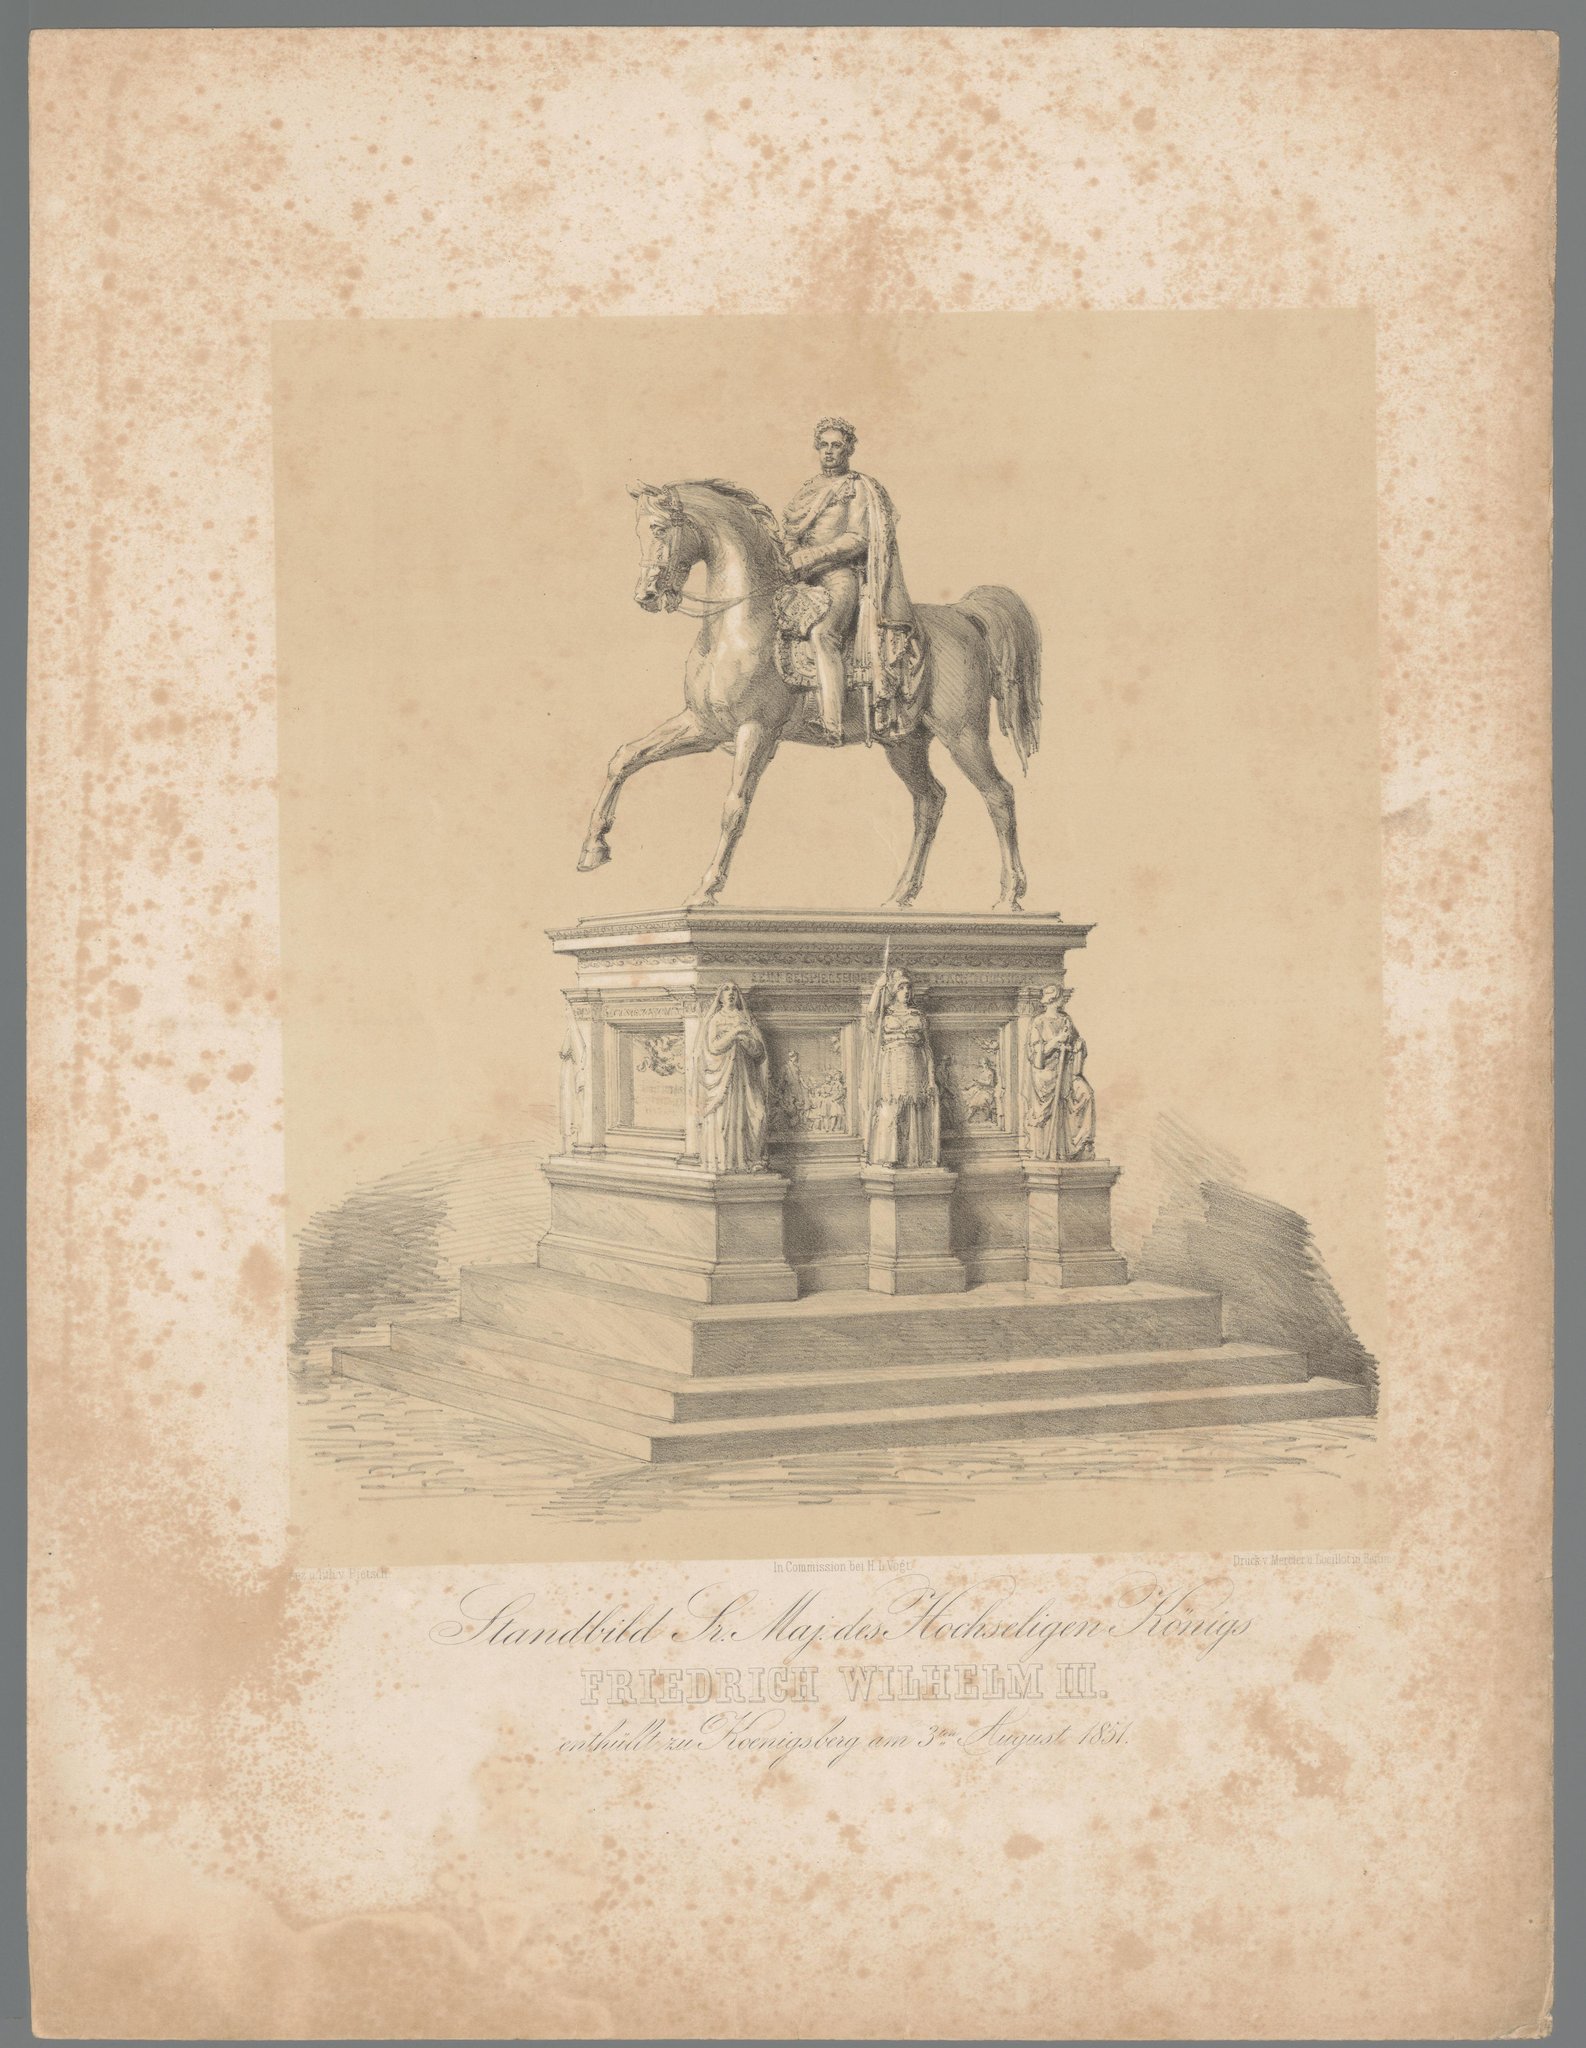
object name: print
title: Standbild Sr. Maj. des Hochseligen Königs Friedrich Wilhelm III, enthüllt zu Koenigsberg am 3ten August 1851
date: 1851-1860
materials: paper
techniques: tone lithography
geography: berlin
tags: berlin, frederik willem iii koning van pruisen, riding a horse, ass, or mule; rider, horseman, monument, statue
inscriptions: collector's mark: Lugt 2228